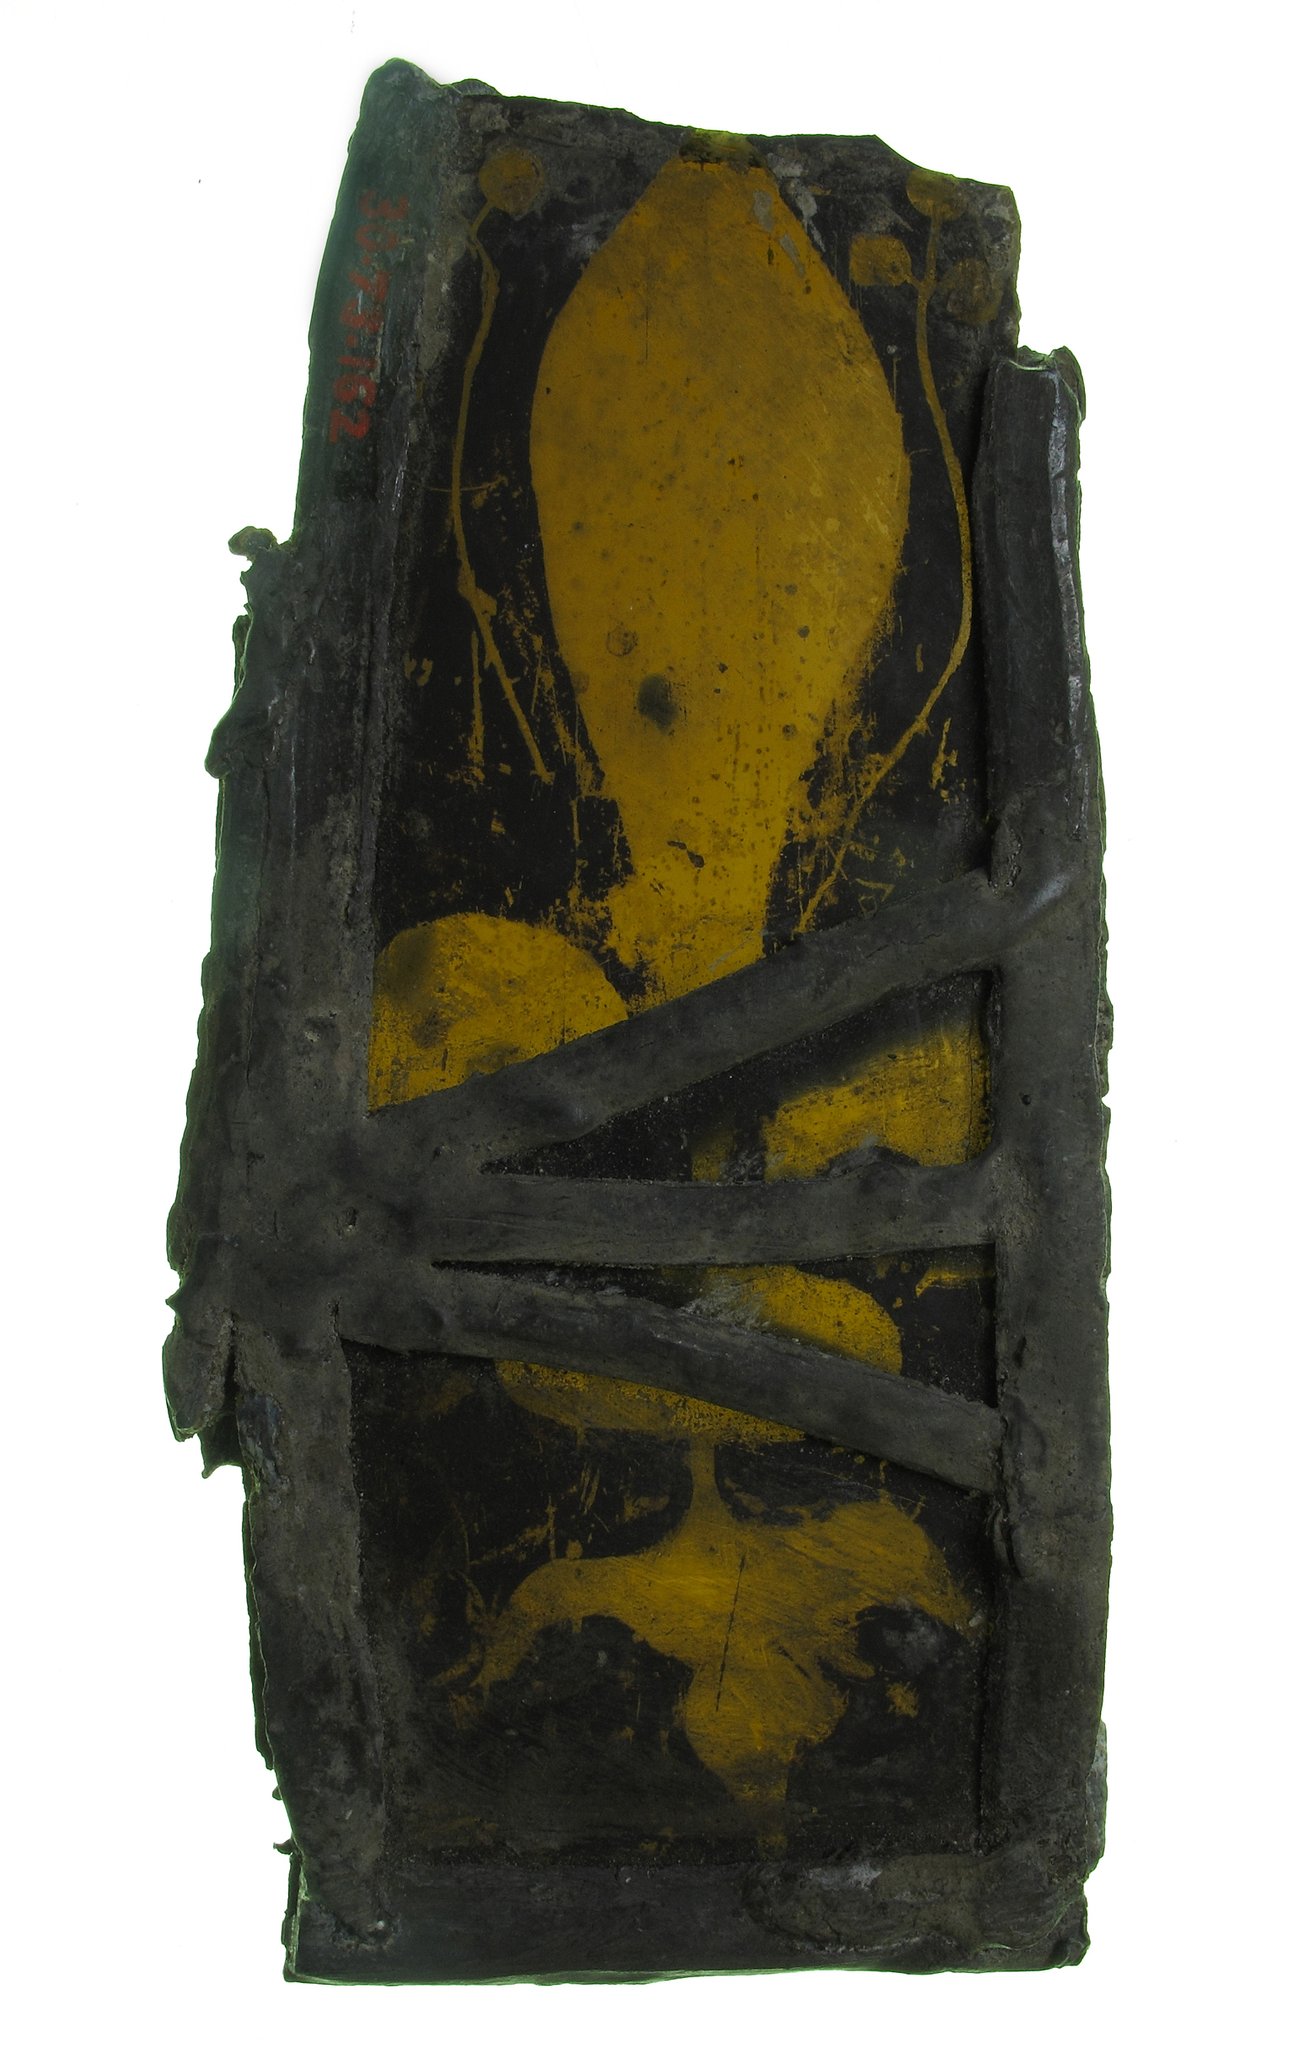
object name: fragment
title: Glass Fragment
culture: european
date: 1301-1400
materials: glass, metal